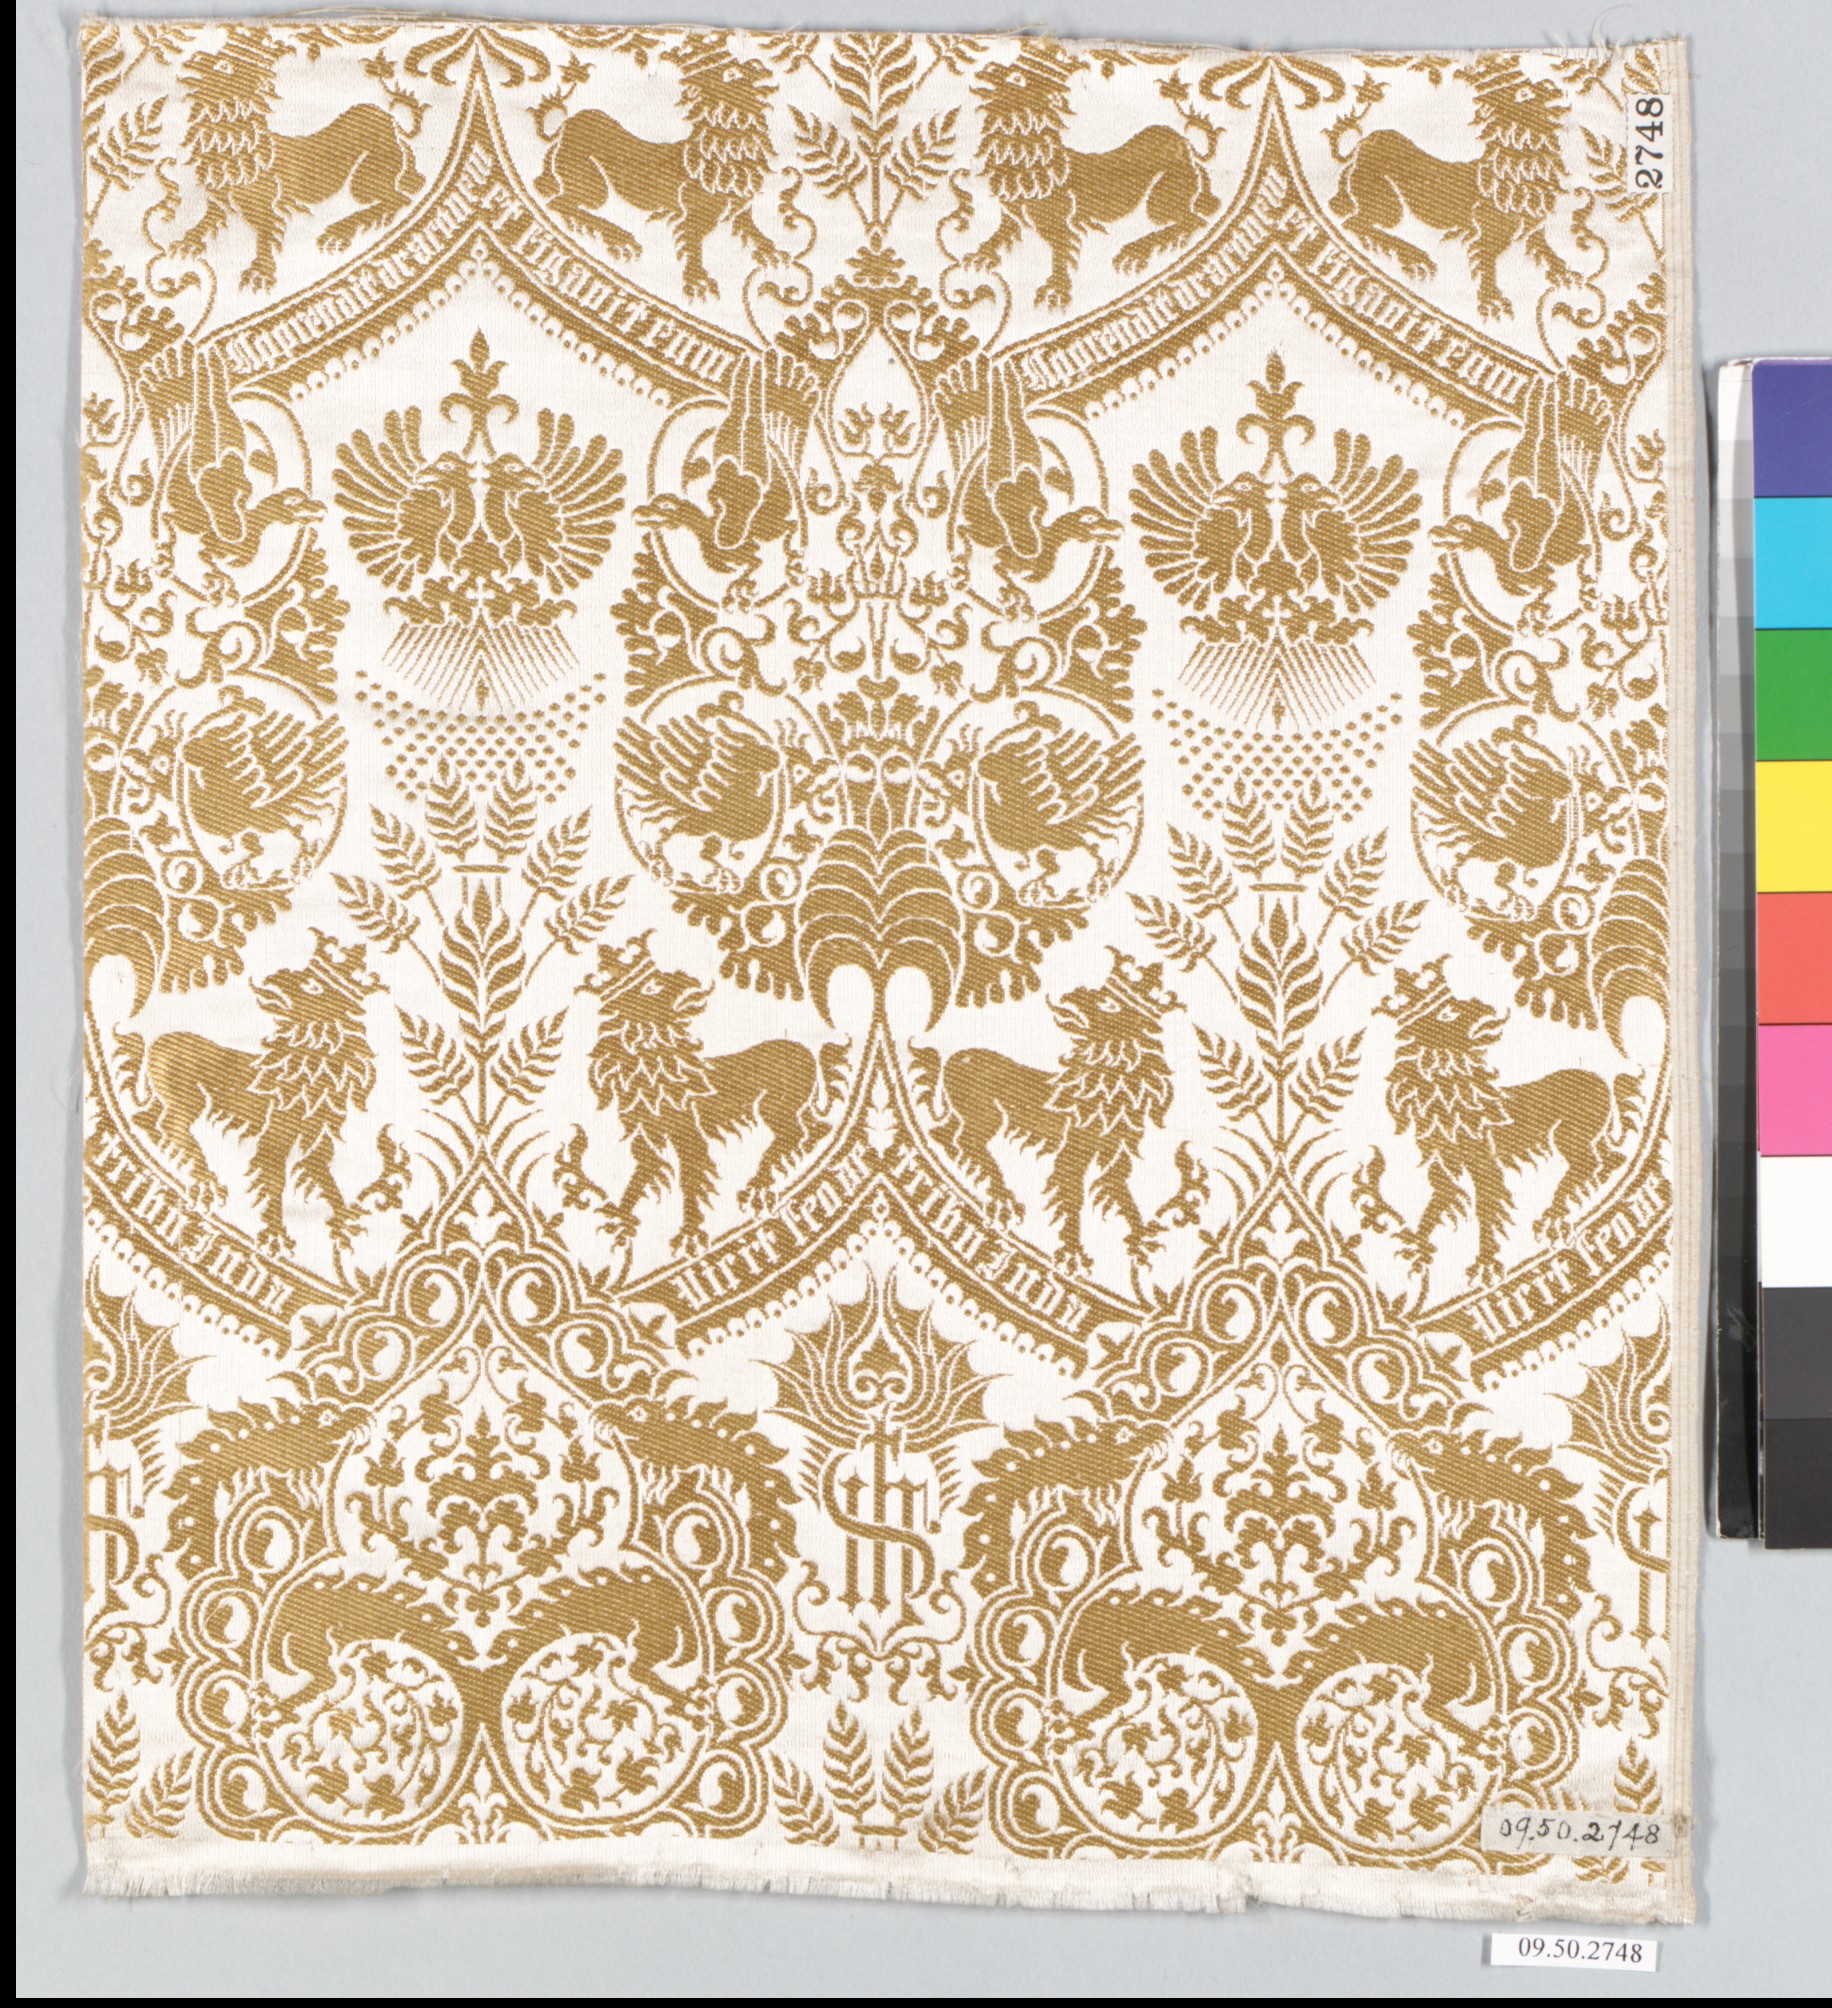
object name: piece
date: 1801-1900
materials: silk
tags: birds,lions,coat of arms